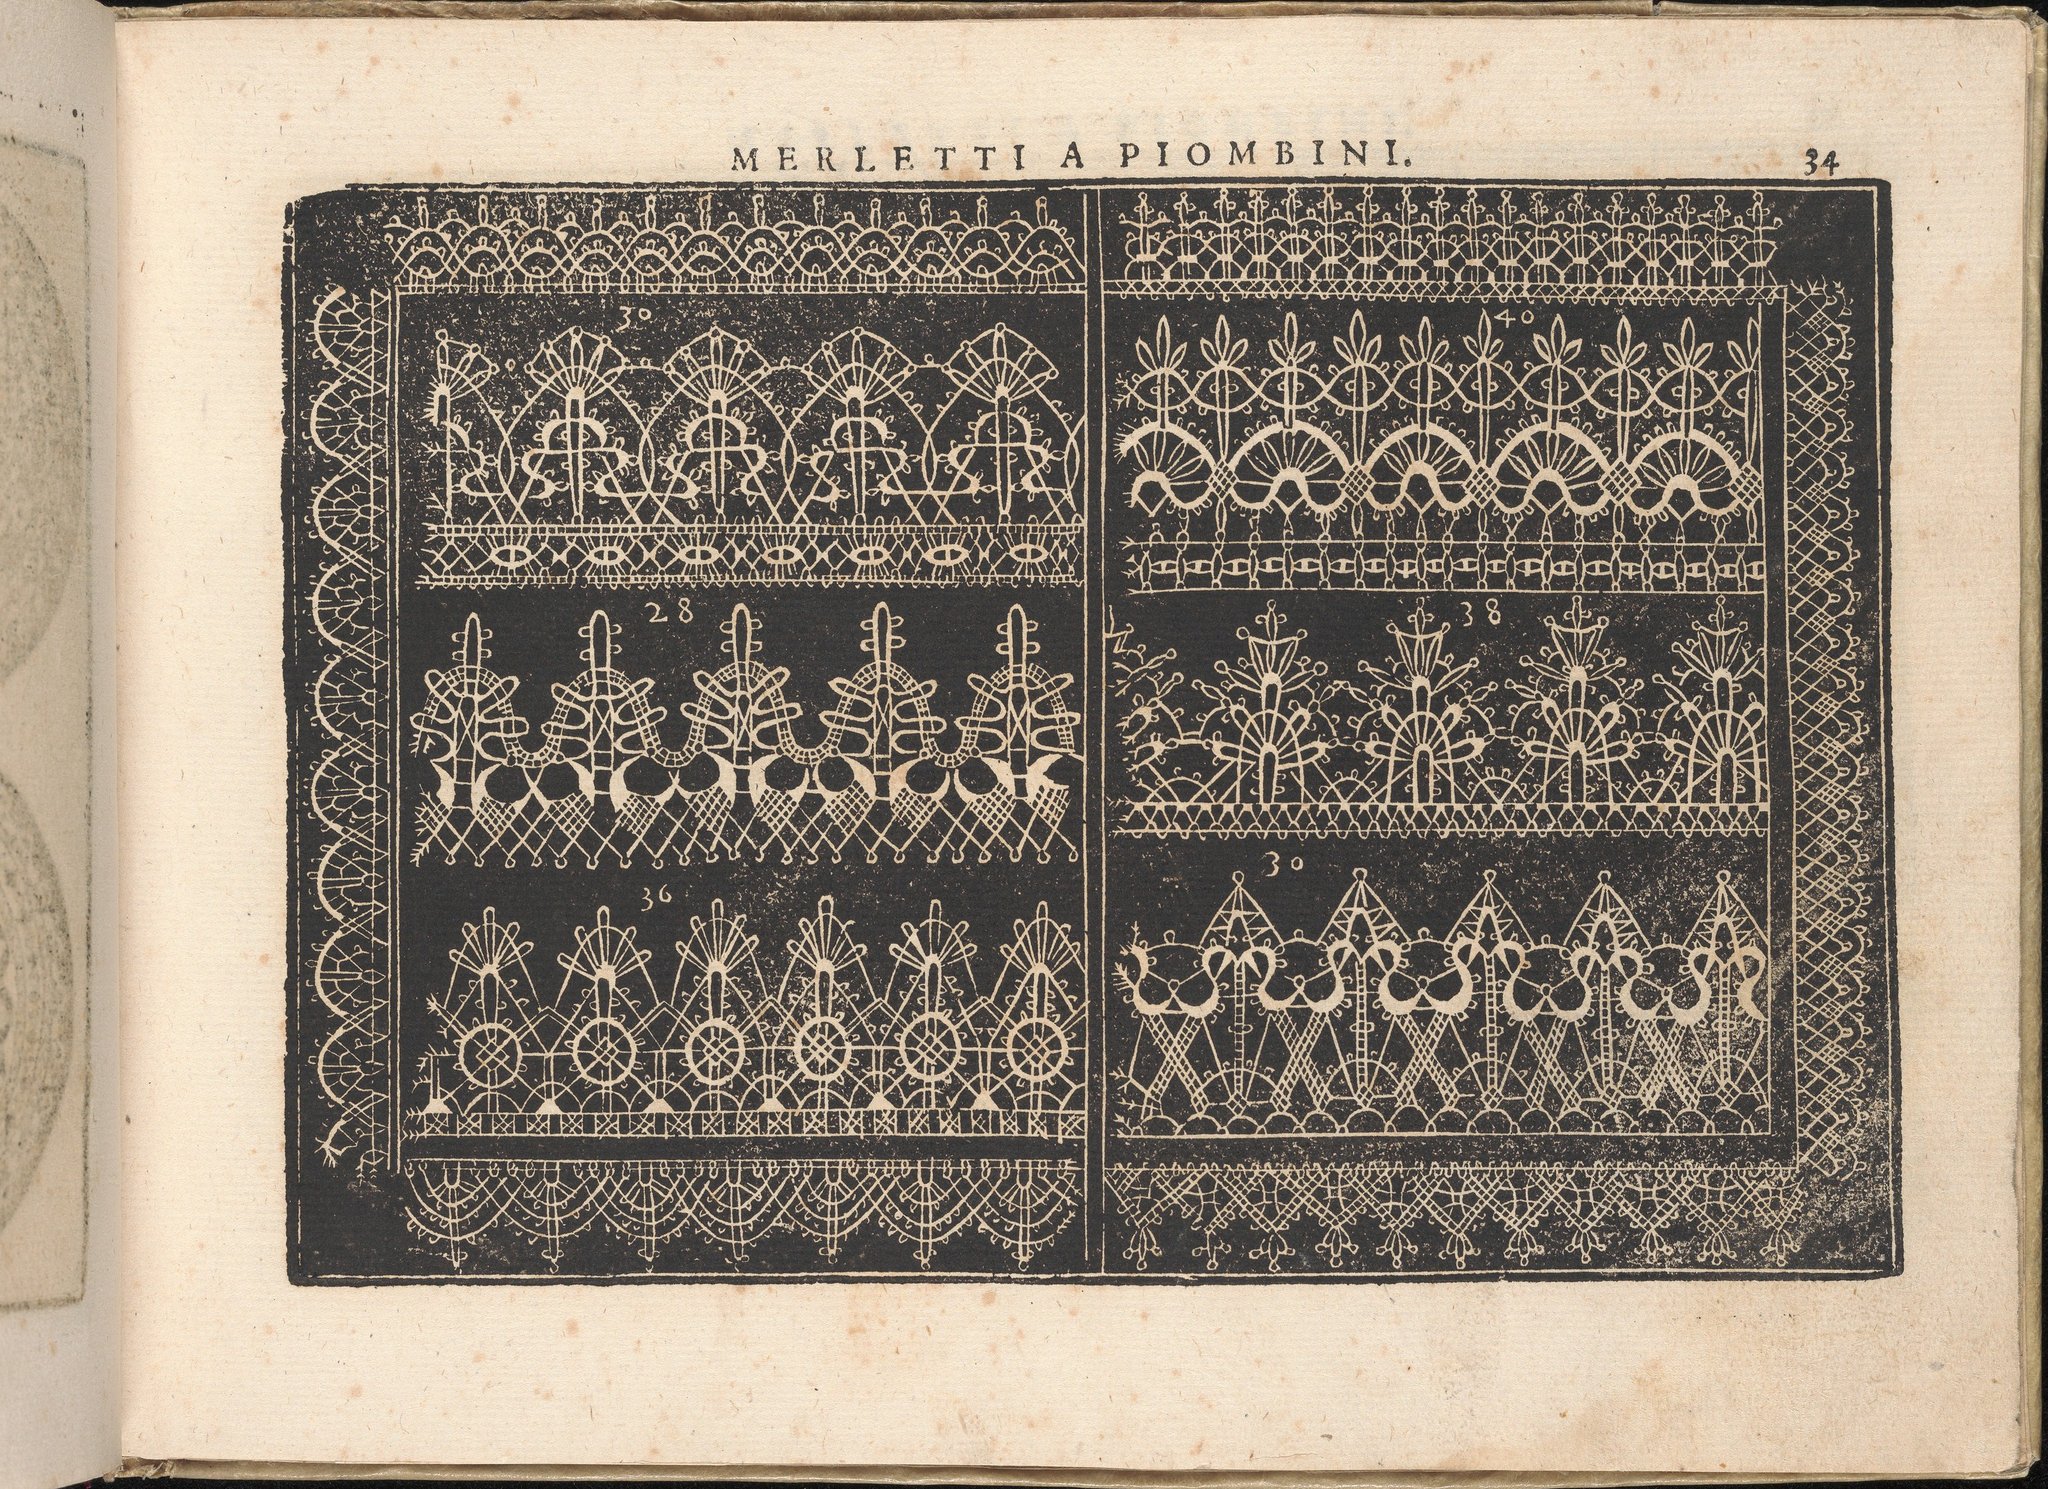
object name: book print ornament architecture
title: Fiore D'Ogni Virtu Per le Nobili Et Honeste Matrone, page 34 (recto)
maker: isabella catanea parasole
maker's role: designer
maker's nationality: italian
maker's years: 1565-1625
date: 1610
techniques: woodcut